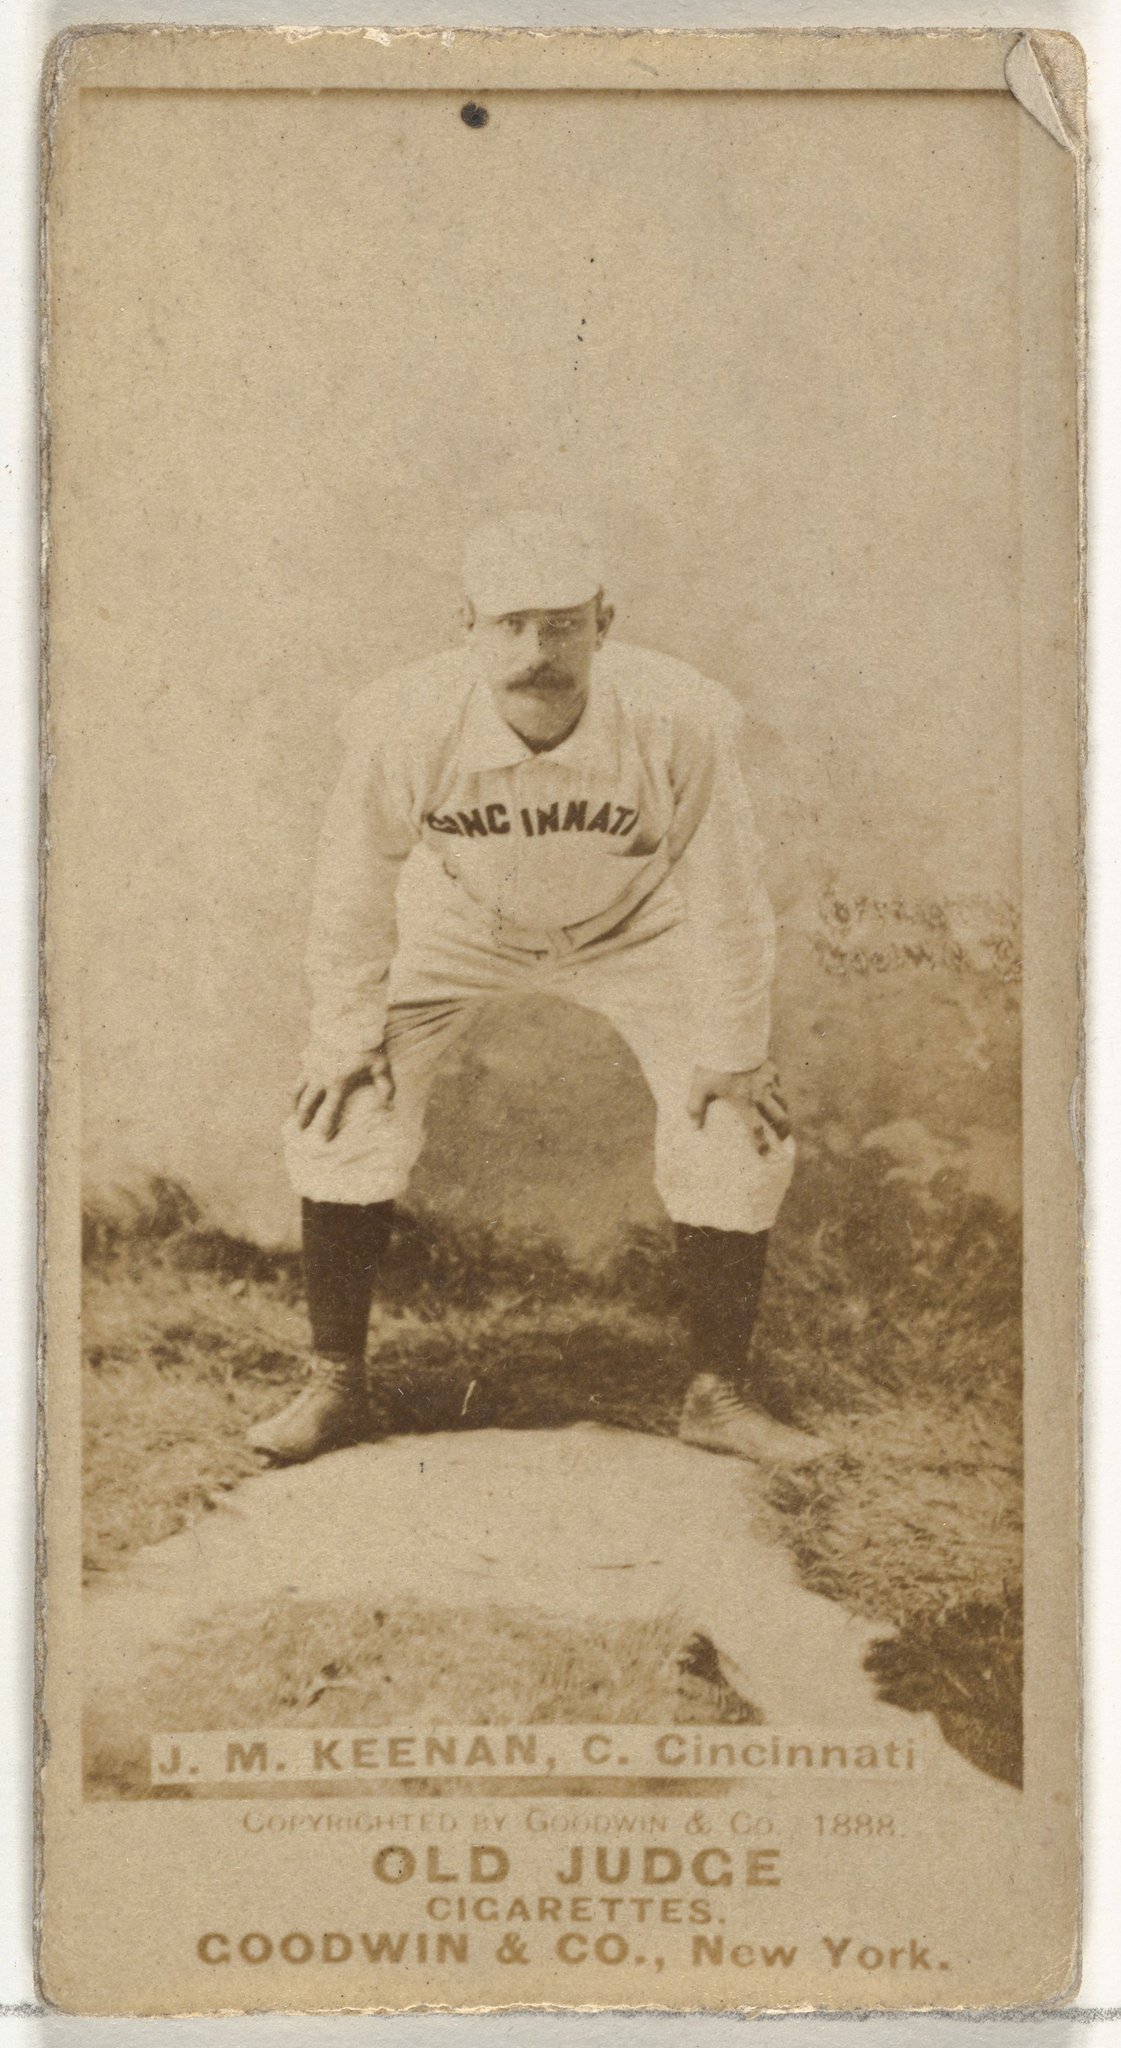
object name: baseball card, photograph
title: James William "Jim" Keenan, Catcher, Cincinnati, from the Old Judge series (N172) for Old Judge Cigarettes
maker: goodwin & company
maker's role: publisher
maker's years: 1850-1950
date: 1888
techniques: albumen silver print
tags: men,portraits,baseball,athletes